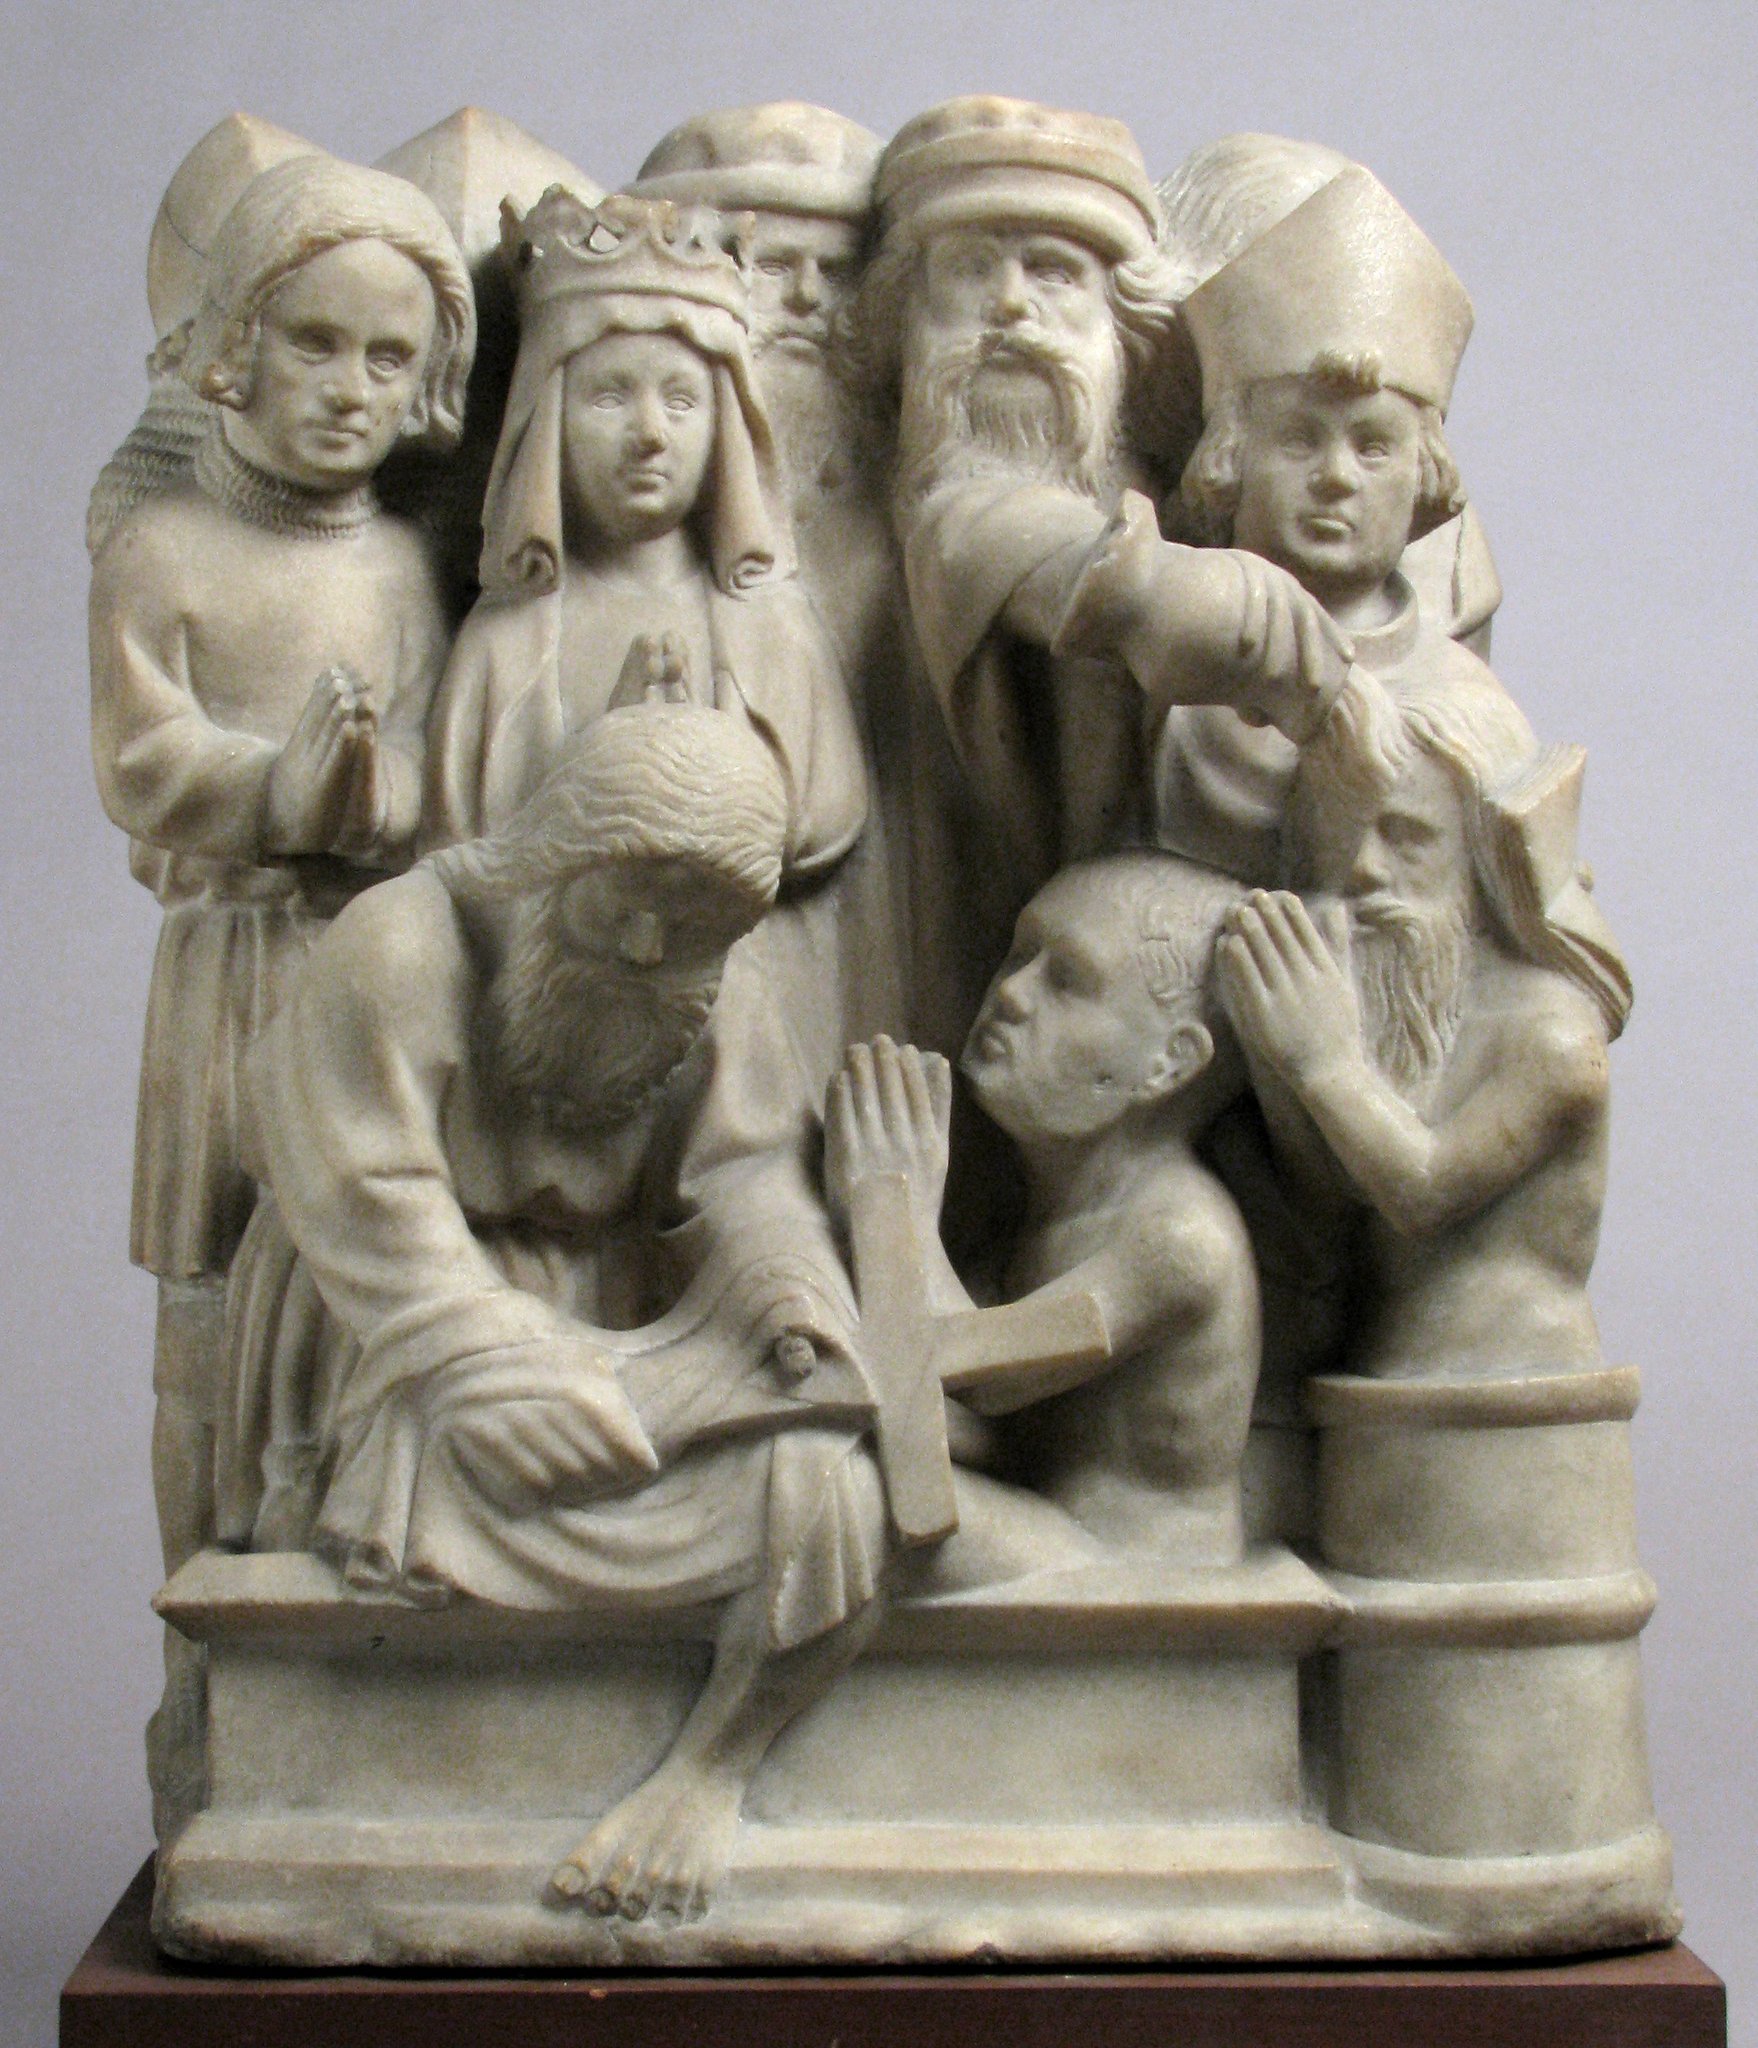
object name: relief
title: Relief with Scene from the Legend of the True Cross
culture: south netherlandish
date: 1400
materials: marble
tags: cross,saint helena